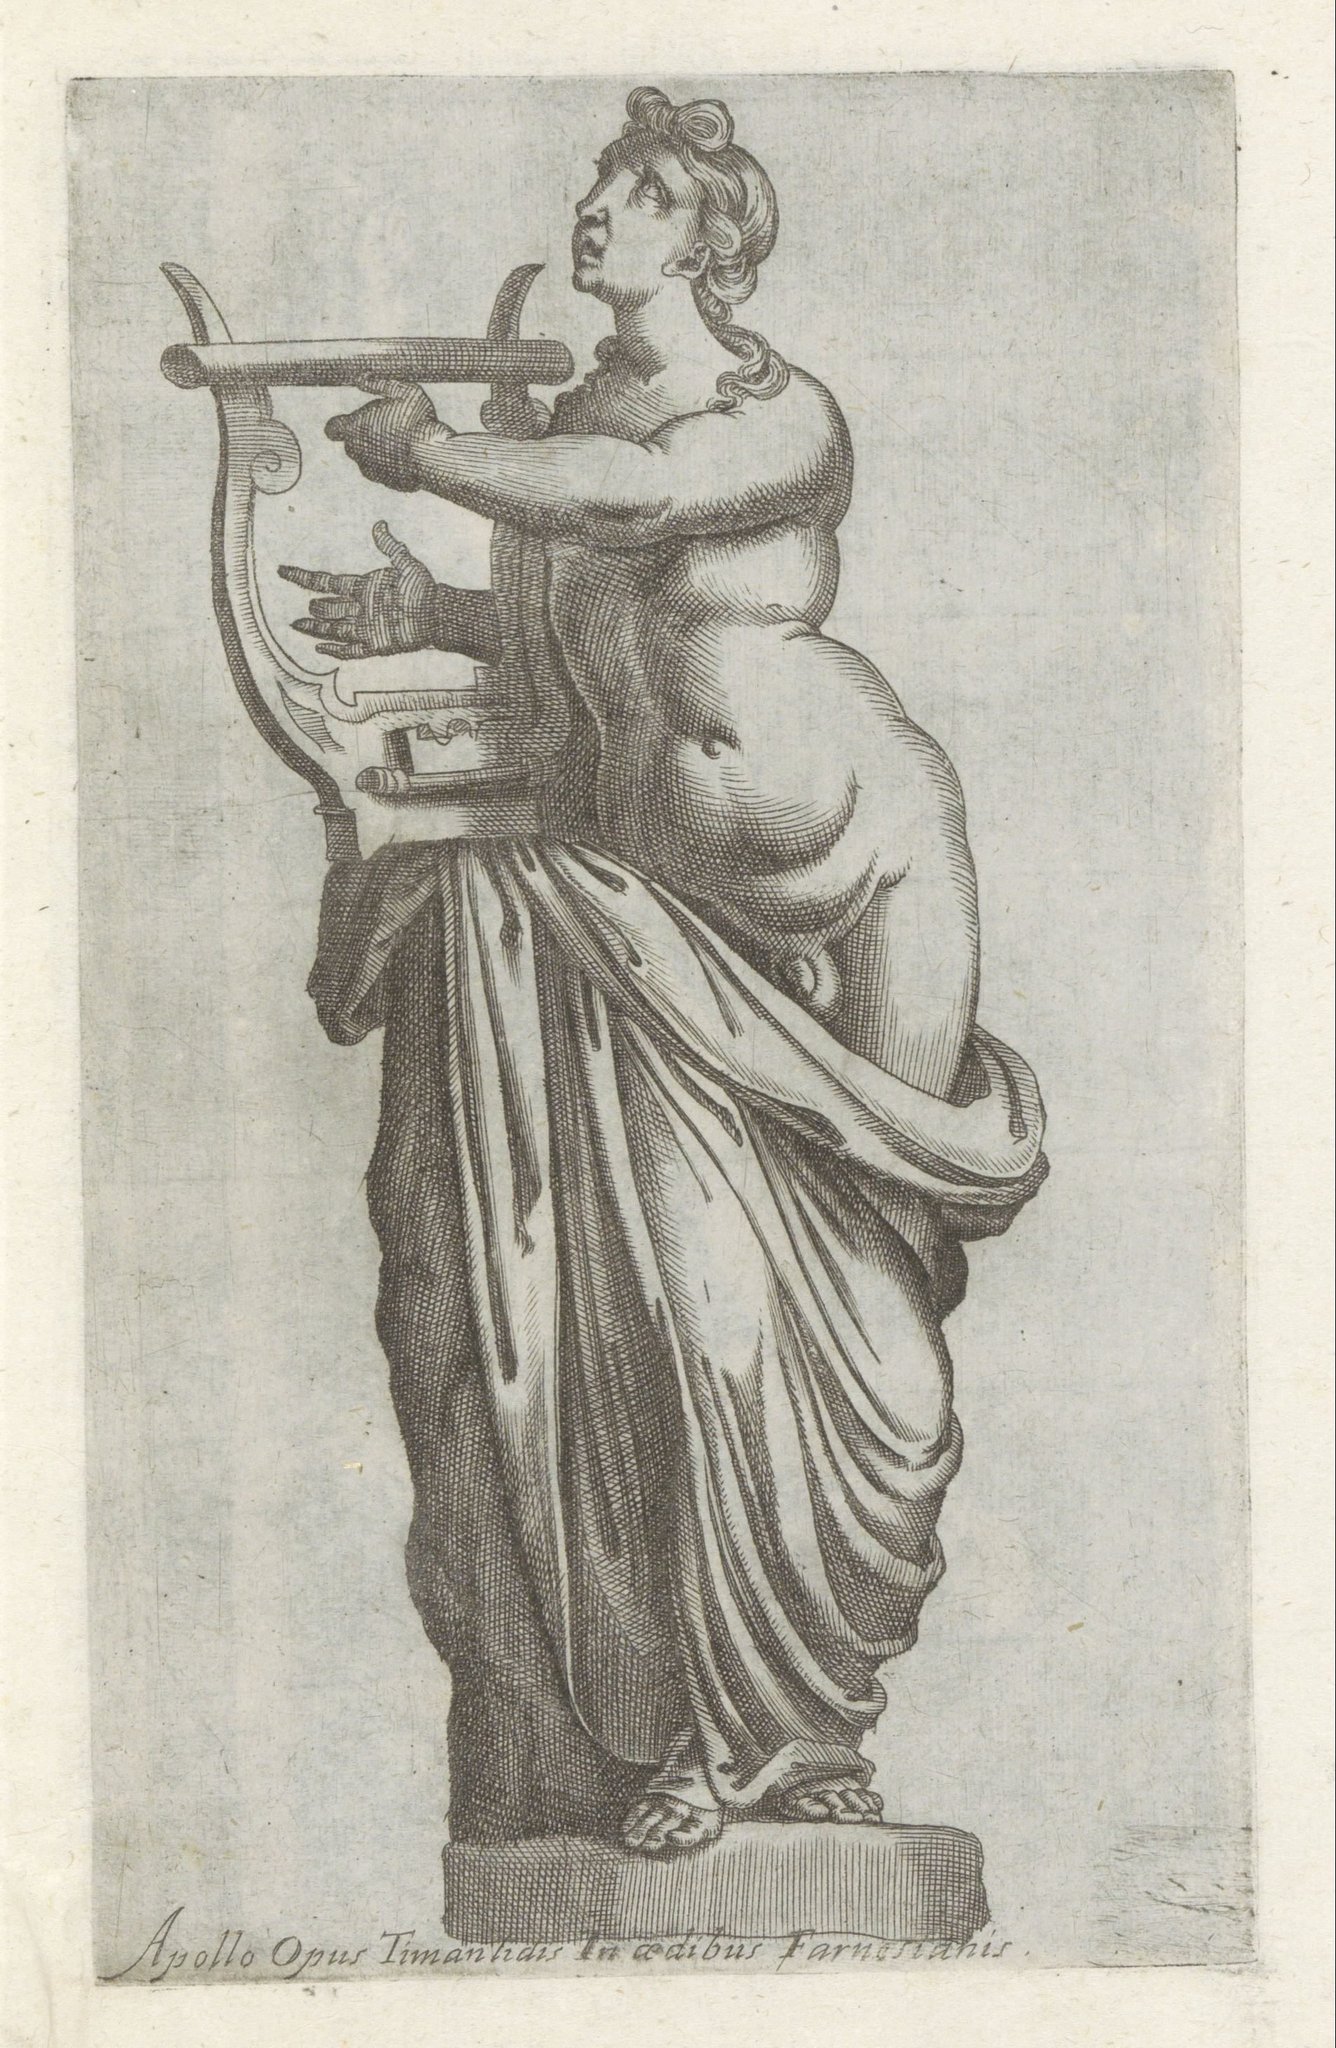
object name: album leaf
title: Antiquarum statuarum urbis Romae quae in publicis locis visuntur icones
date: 1584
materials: paper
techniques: engraving, intaglio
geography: italy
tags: (story of) apollo (phoebus), piece of sculpture, reproduction of a piece of sculpture, attributes of apollo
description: Deze prent maakt deel uit van een set van 79 prenten (+ titelprent) met voorstellingen van antieke sculpturen in Rome.